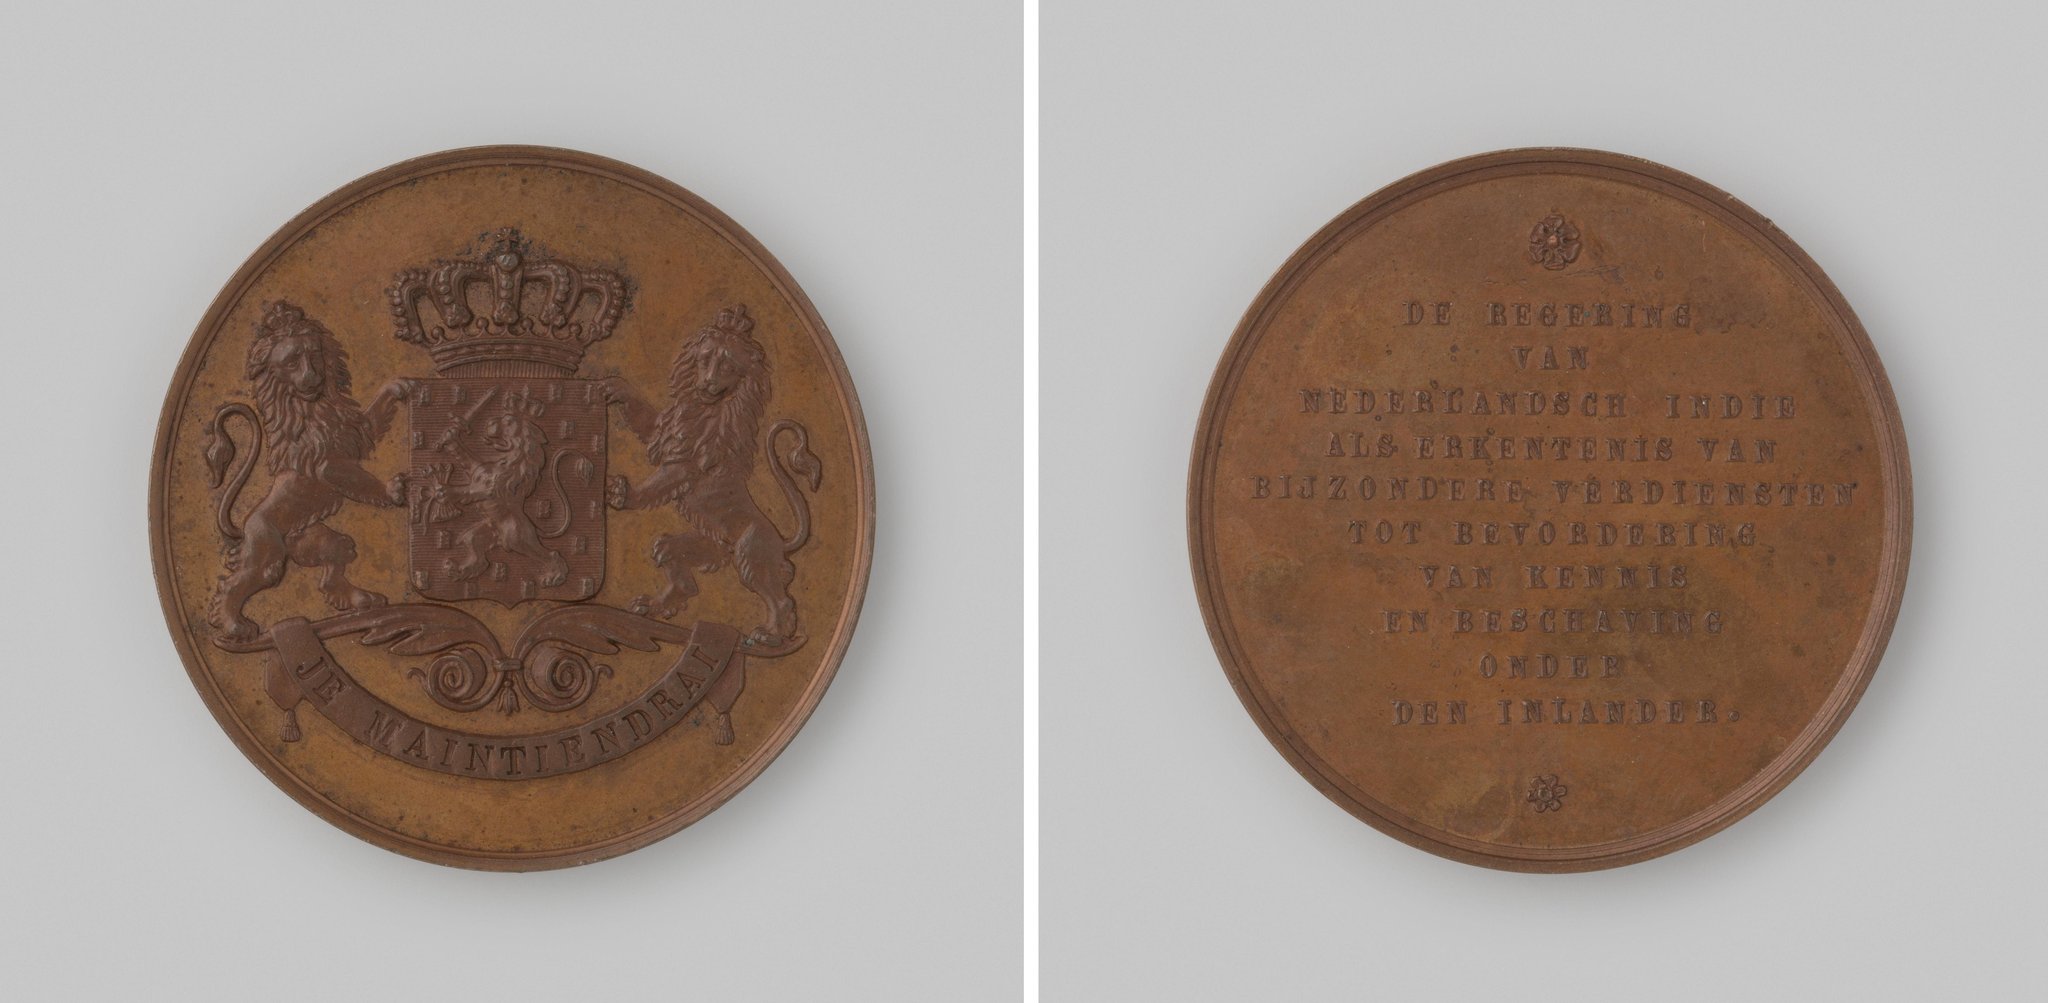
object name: honorary medal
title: Erkenning van verdiensten bij onderricht aan Indonesiërs, door de regering van Nederlands-Indië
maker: Anonymous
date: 1870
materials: bronze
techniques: striking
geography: netherlands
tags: dutch east indies, the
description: Geslagen bronzen penning. Voorzijde: rijkswapen; keerzijde tienregelige tekst tussen bloem- en stervorm: "De regering / van / Nederlandsch Indie / als erkentenis van / bijzondere verdiensten / tot bevordering / van kennis / en beschaving / onder / den inlander."